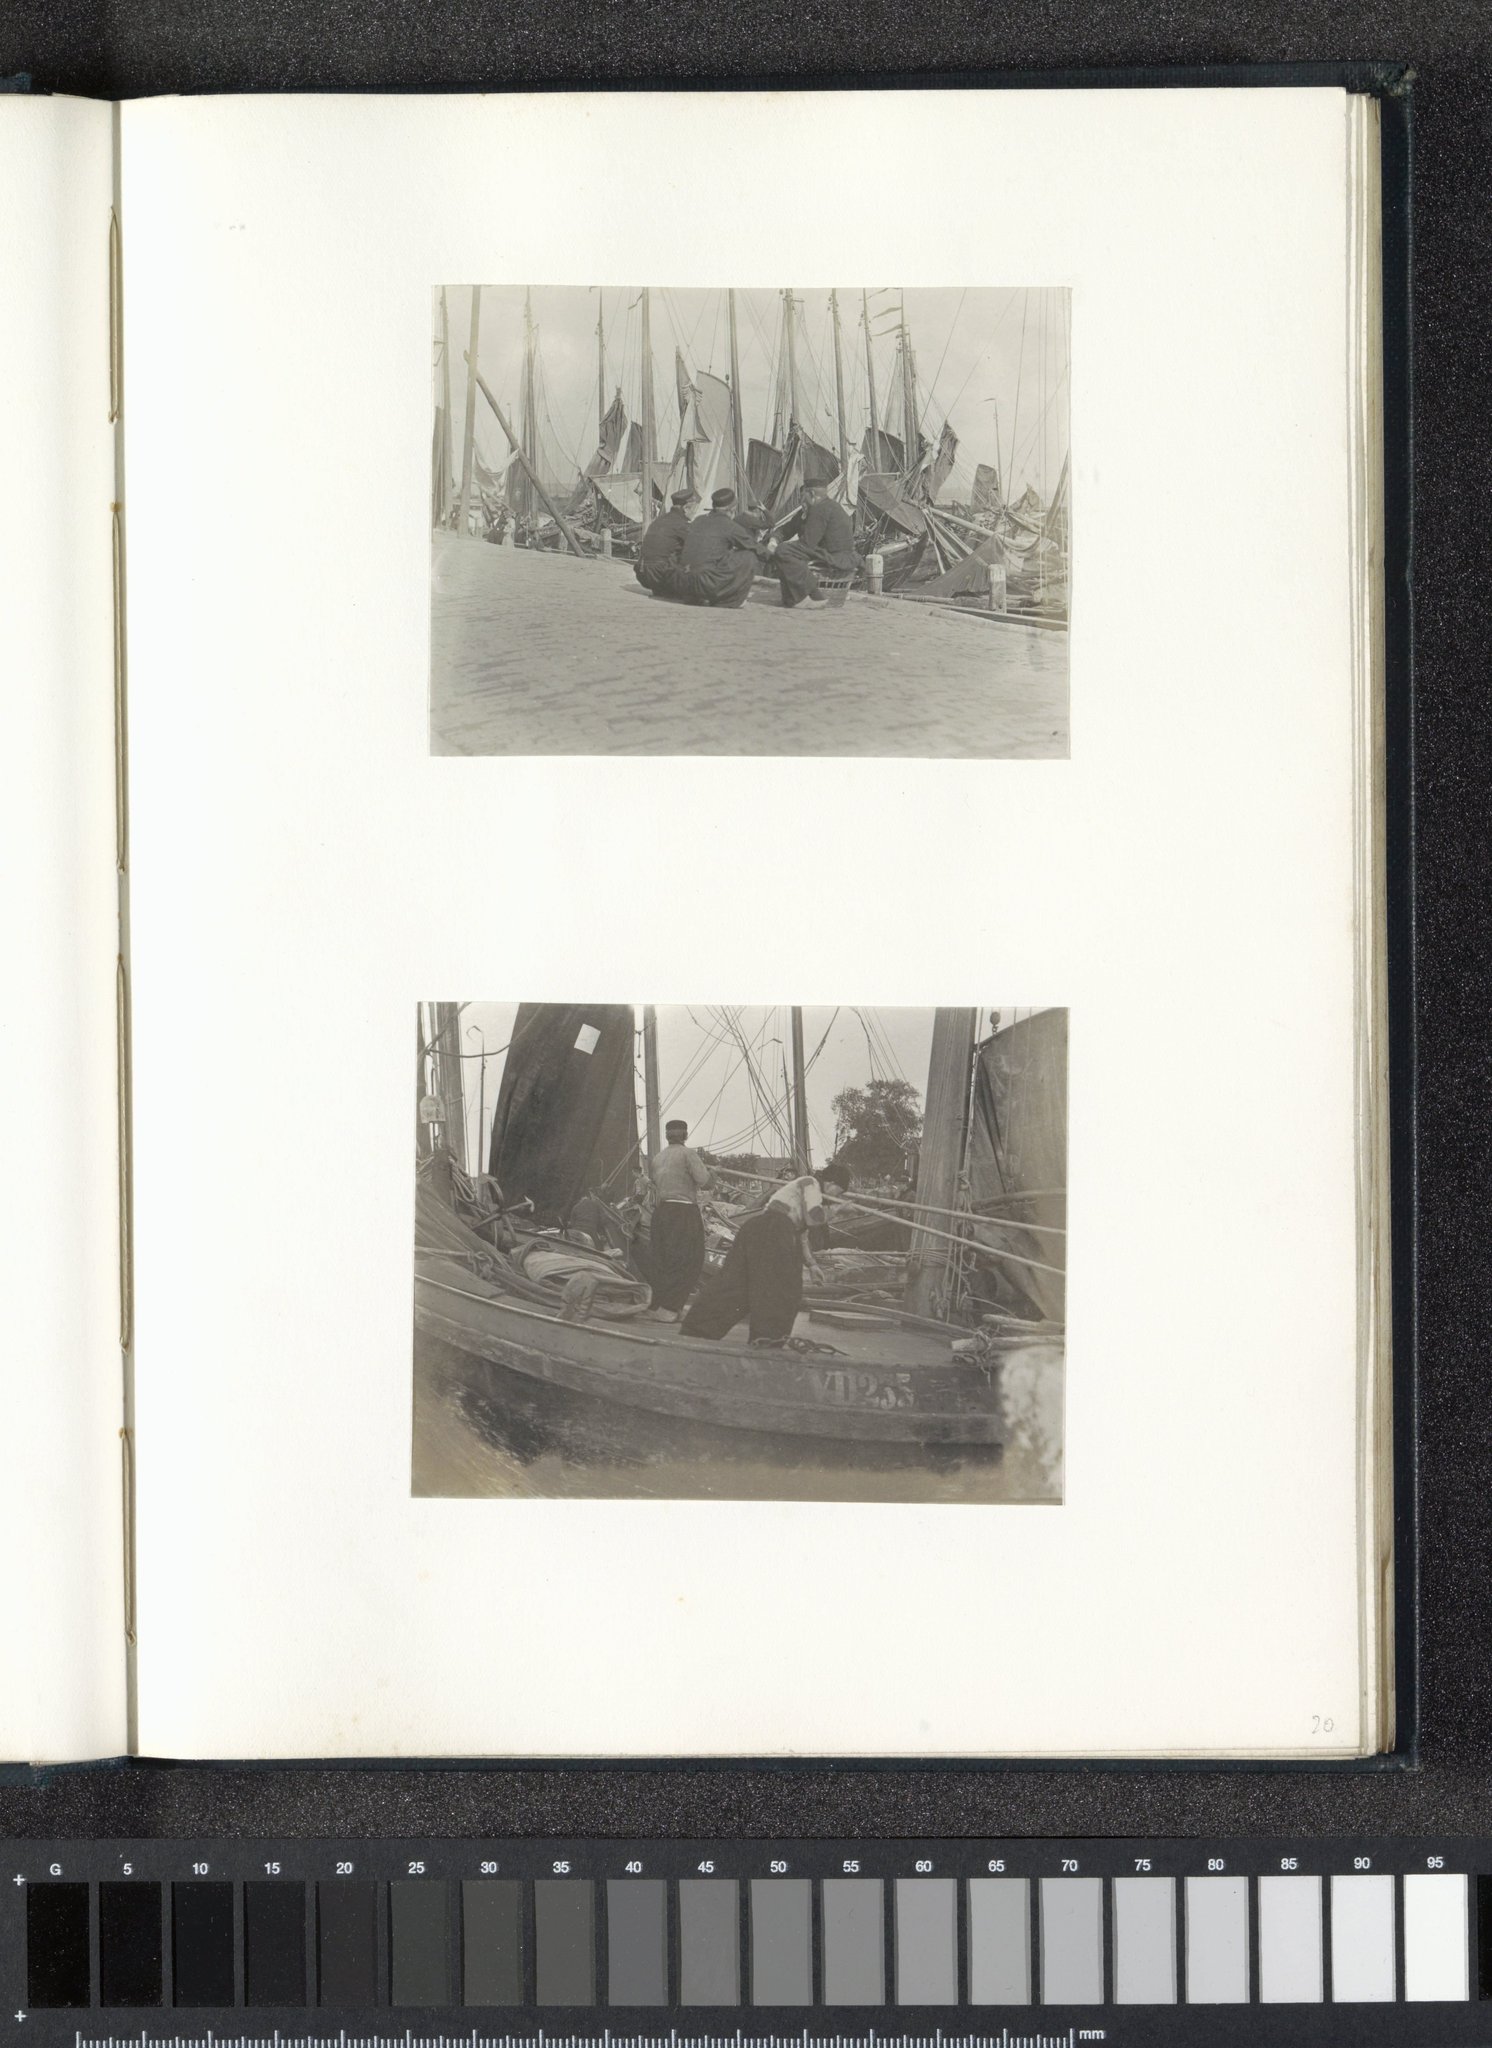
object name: photograph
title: Drie mannen in Volendamse klederdracht zittend op een kade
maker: george hidderley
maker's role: fotograaf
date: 1900-1910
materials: paper, photographic support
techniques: gelatin silver print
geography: volendam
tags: sailing-ship, sailing-boat, folk costume, regional costume (+ men's clothes), pier, quay, wharf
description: Onderdeel van fotoalbum met opnames van Volendam, Dordrecht, Gorinchem en Woudrichem.